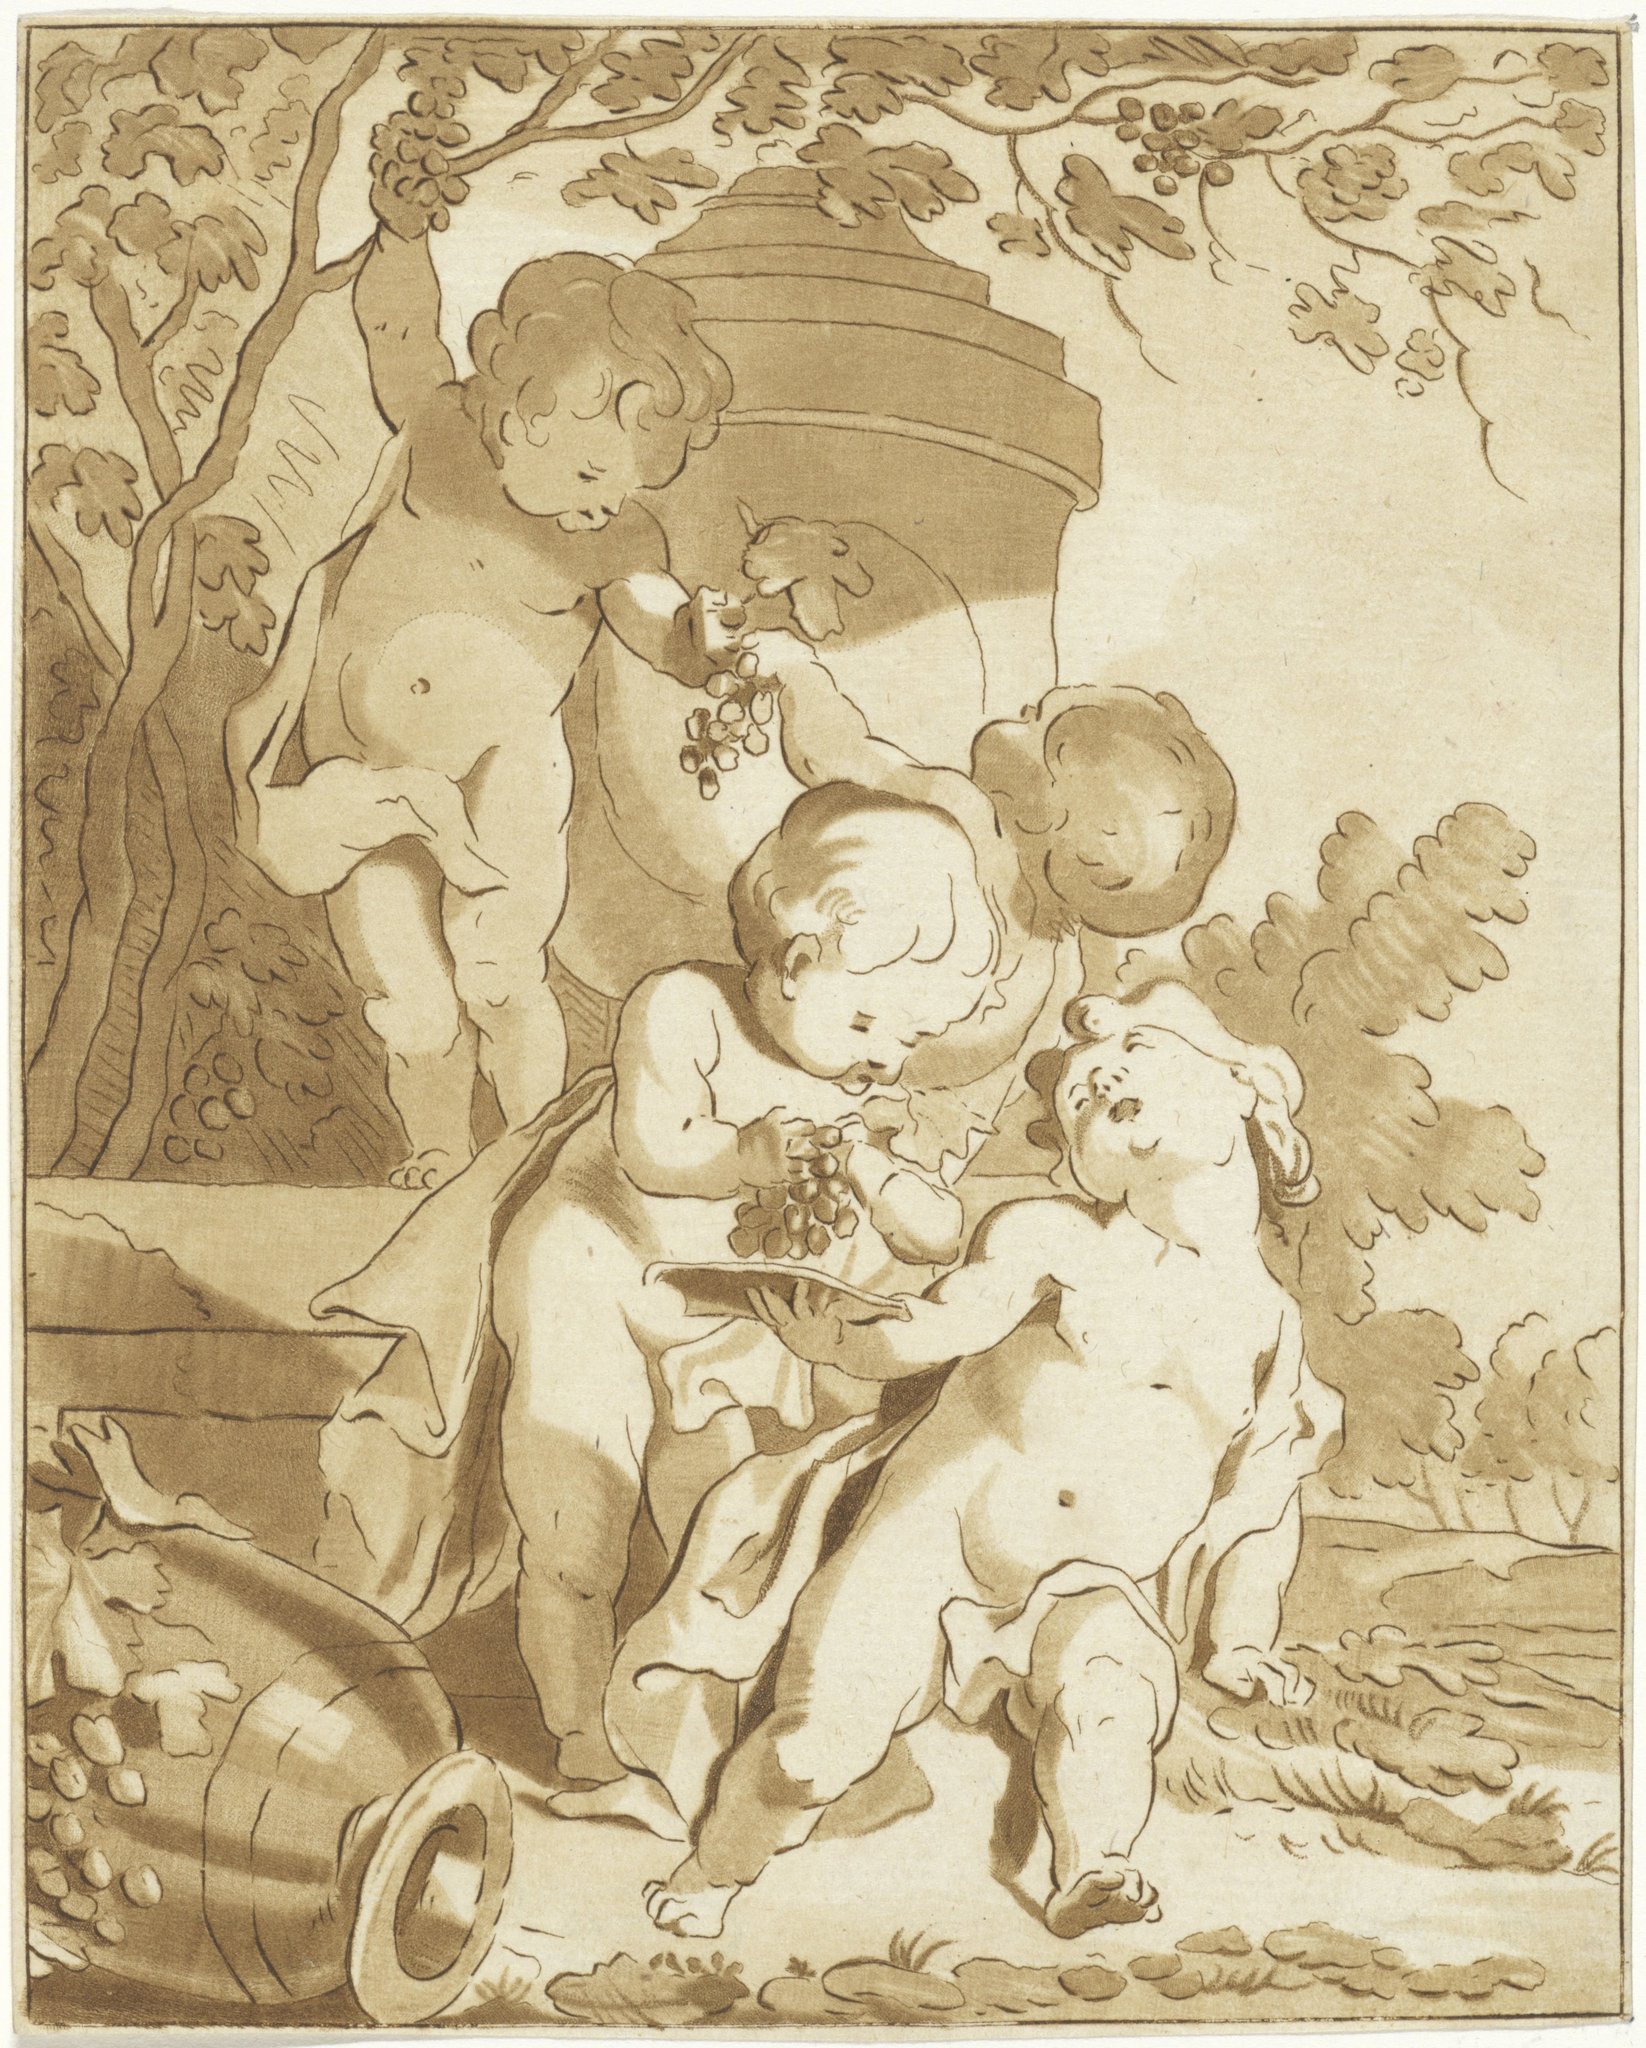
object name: print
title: Vier druiven plukkende putti bij een vaas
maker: bernhard schreuder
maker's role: print maker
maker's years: -1780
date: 1767-1780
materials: paper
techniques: etching, rocker stamped, roulette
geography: netherlands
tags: cupids: 'amores', 'amoretti', 'putti', bunch of grapes, garden vase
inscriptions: collector's mark: Lugt 2228